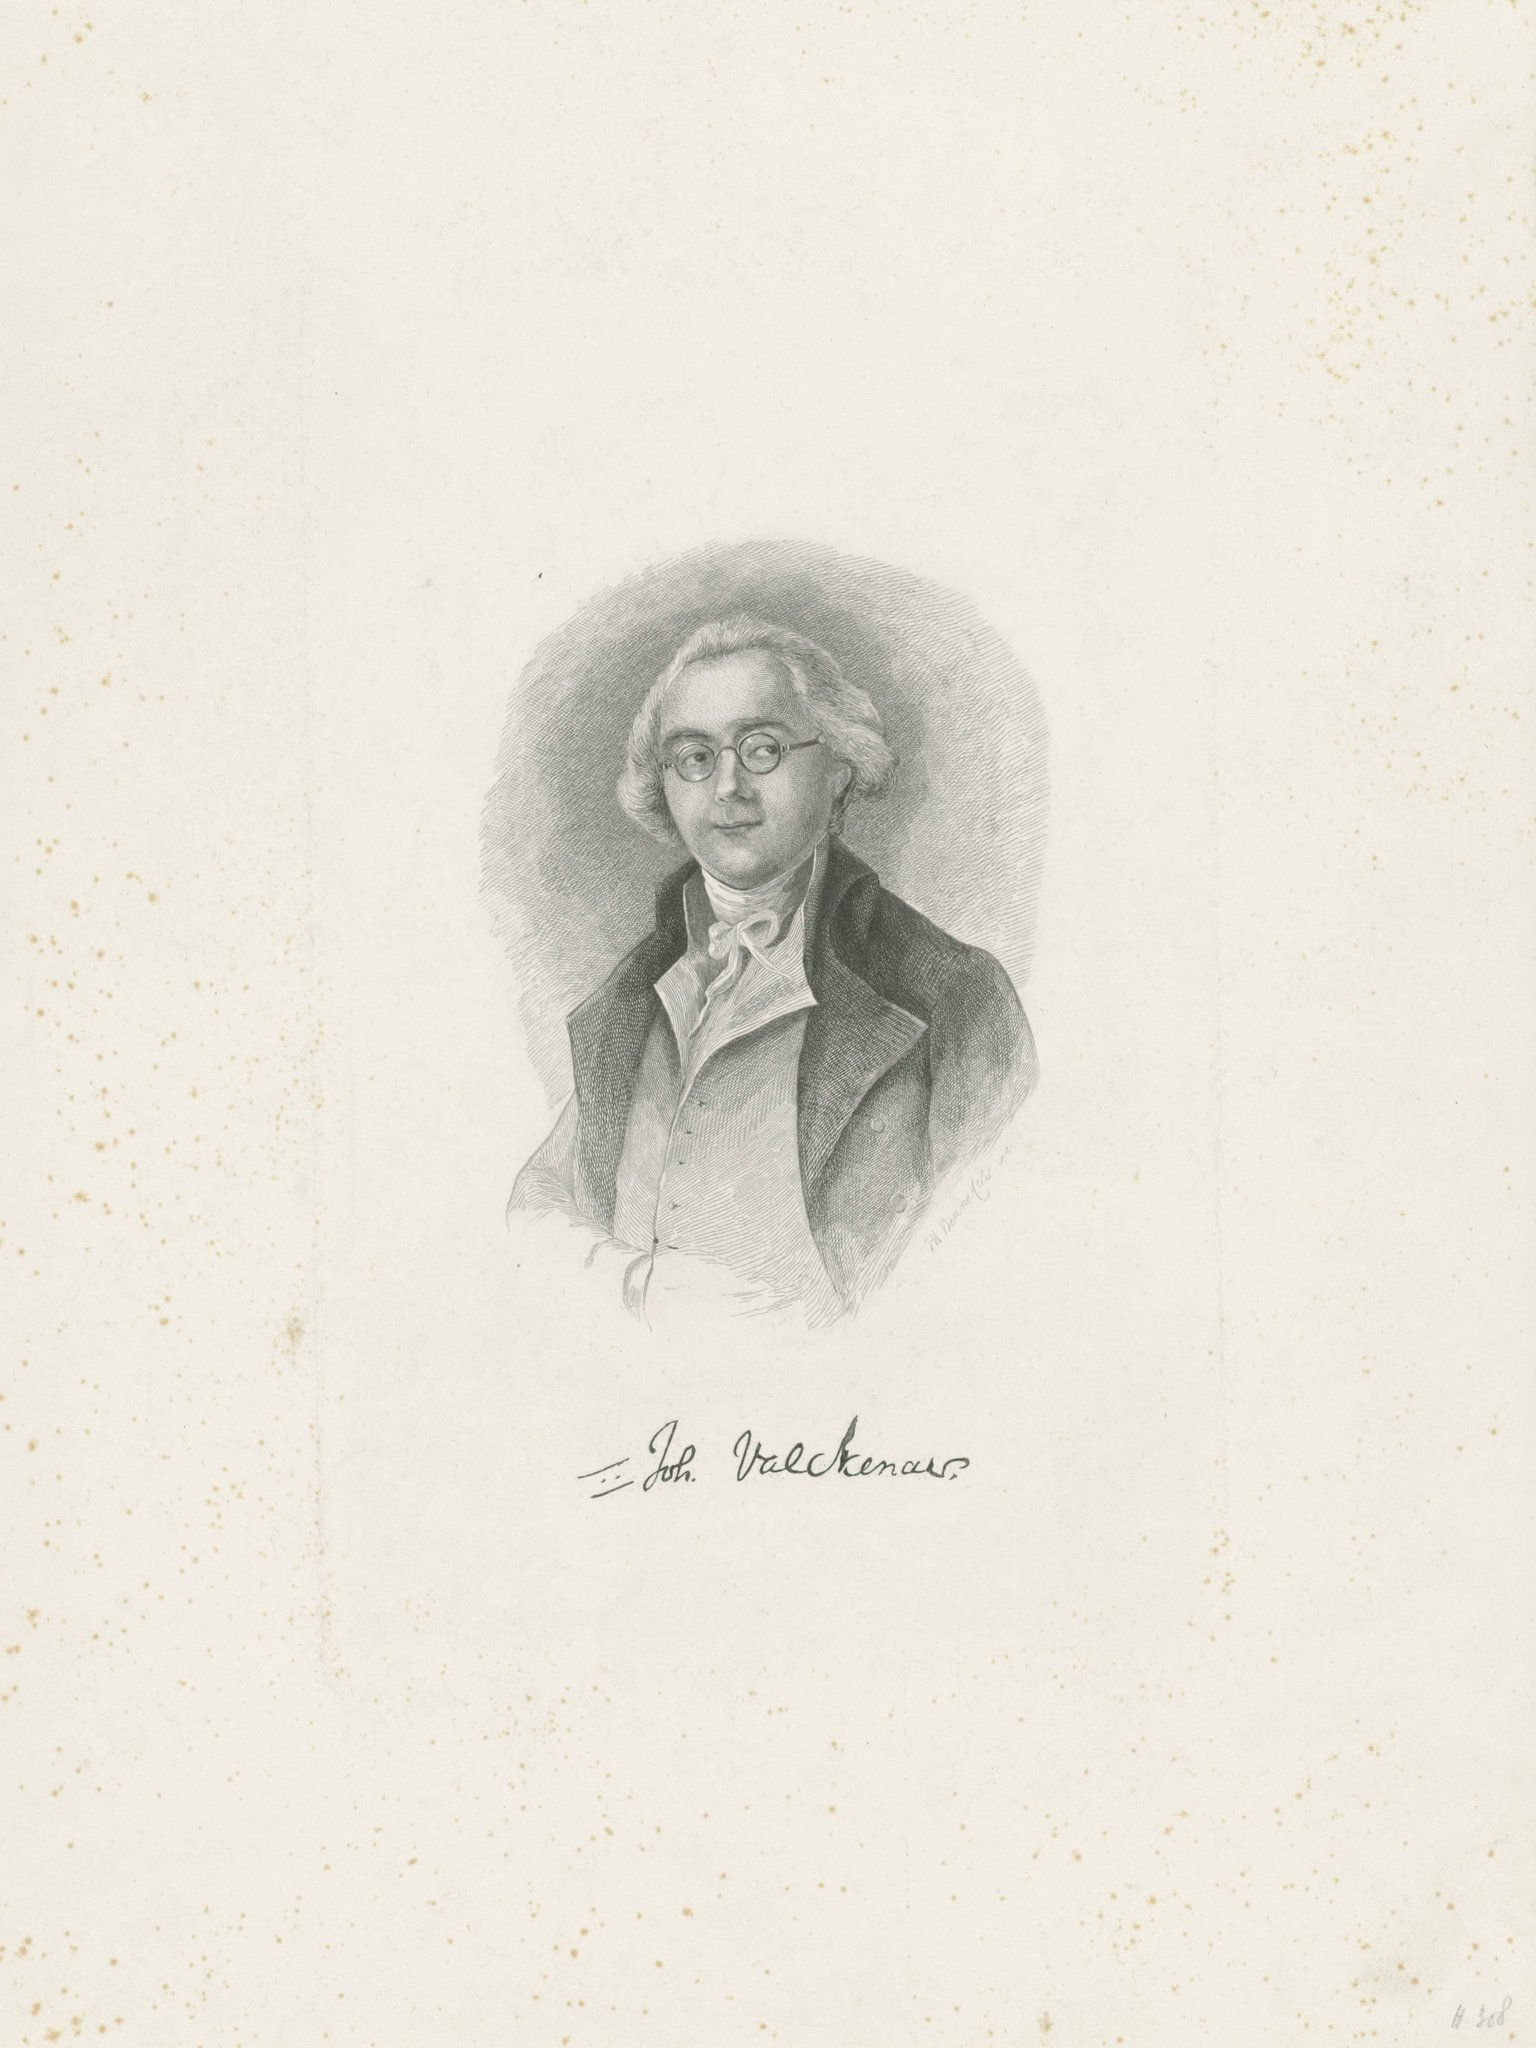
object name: print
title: Portret van Johan Valckenaer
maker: johann heinrich maria hubert rennefeld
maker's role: print maker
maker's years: 1832-1877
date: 1845-1877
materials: paper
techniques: engraving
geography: amsterdam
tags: johan valckenaer, eyeglasses, spectacles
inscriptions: collector's mark: Lugt 2228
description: Portret van Johan Valckenaer, jurist, diplomaat en patriot.